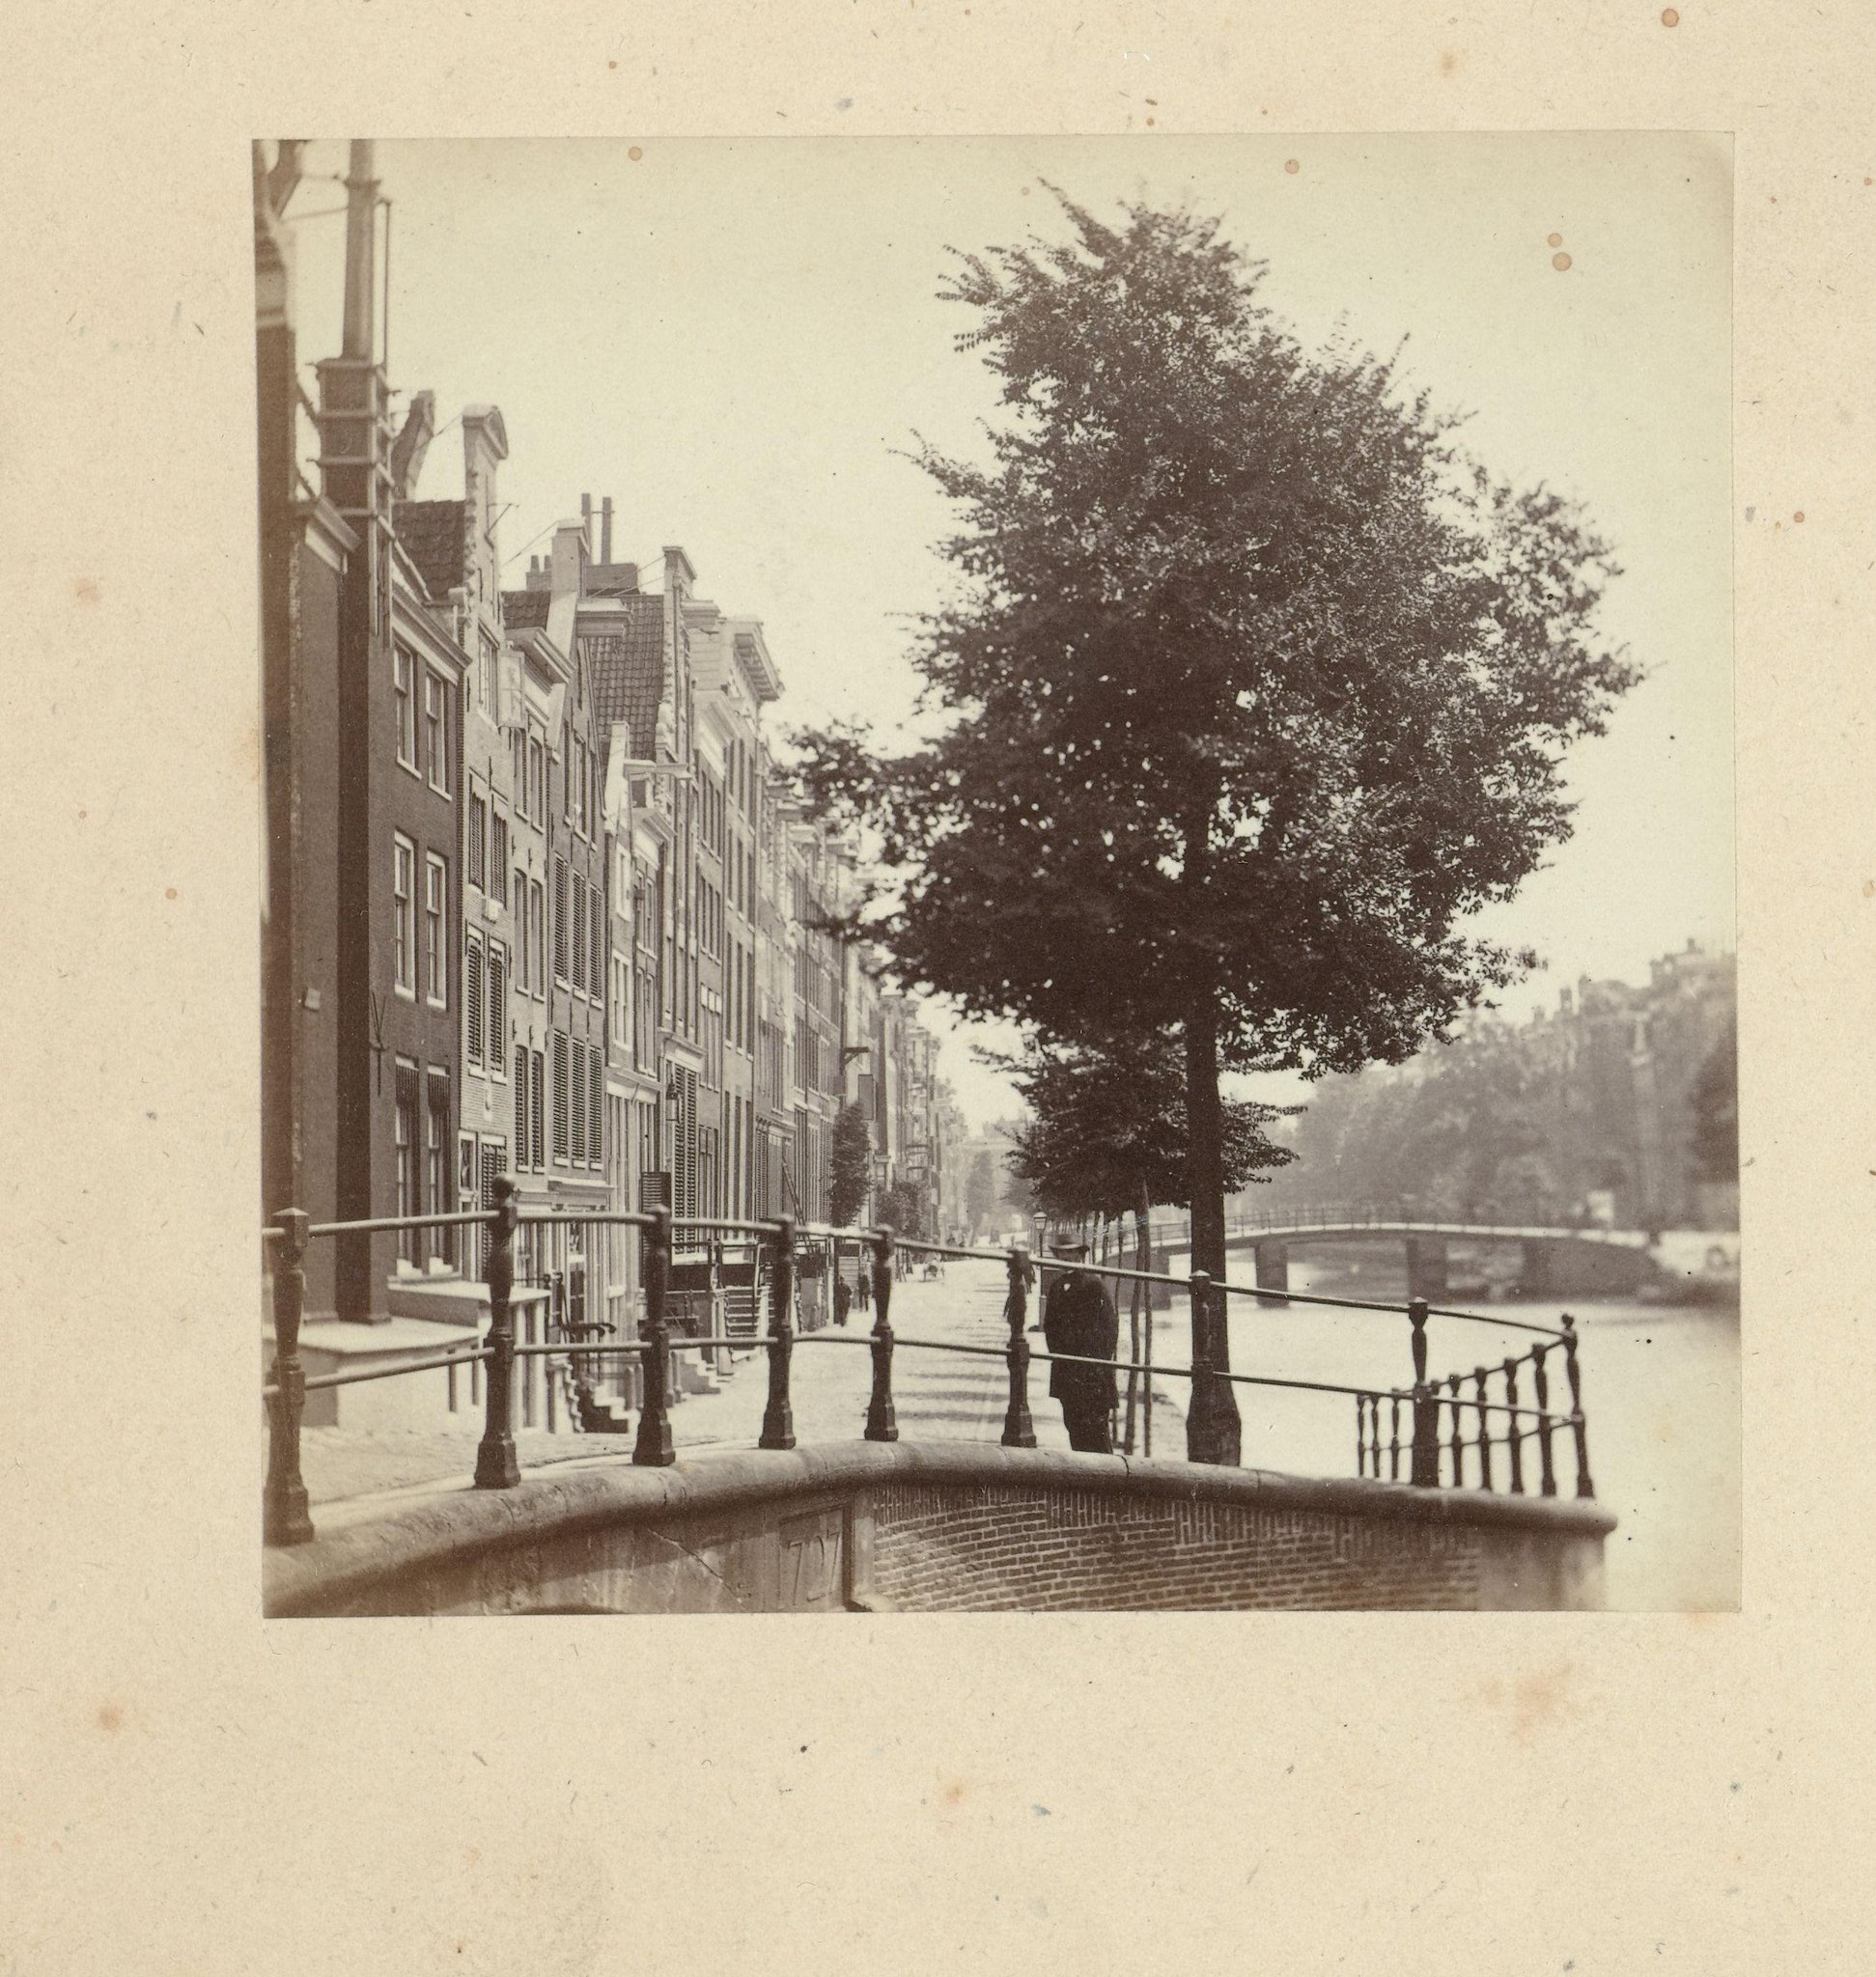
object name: photograph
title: De Heerengracht bij de Leidschegracht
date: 1860-1875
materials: cardboard, paper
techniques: albumen print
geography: amsterdam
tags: bridge in city across river, canal, etc.